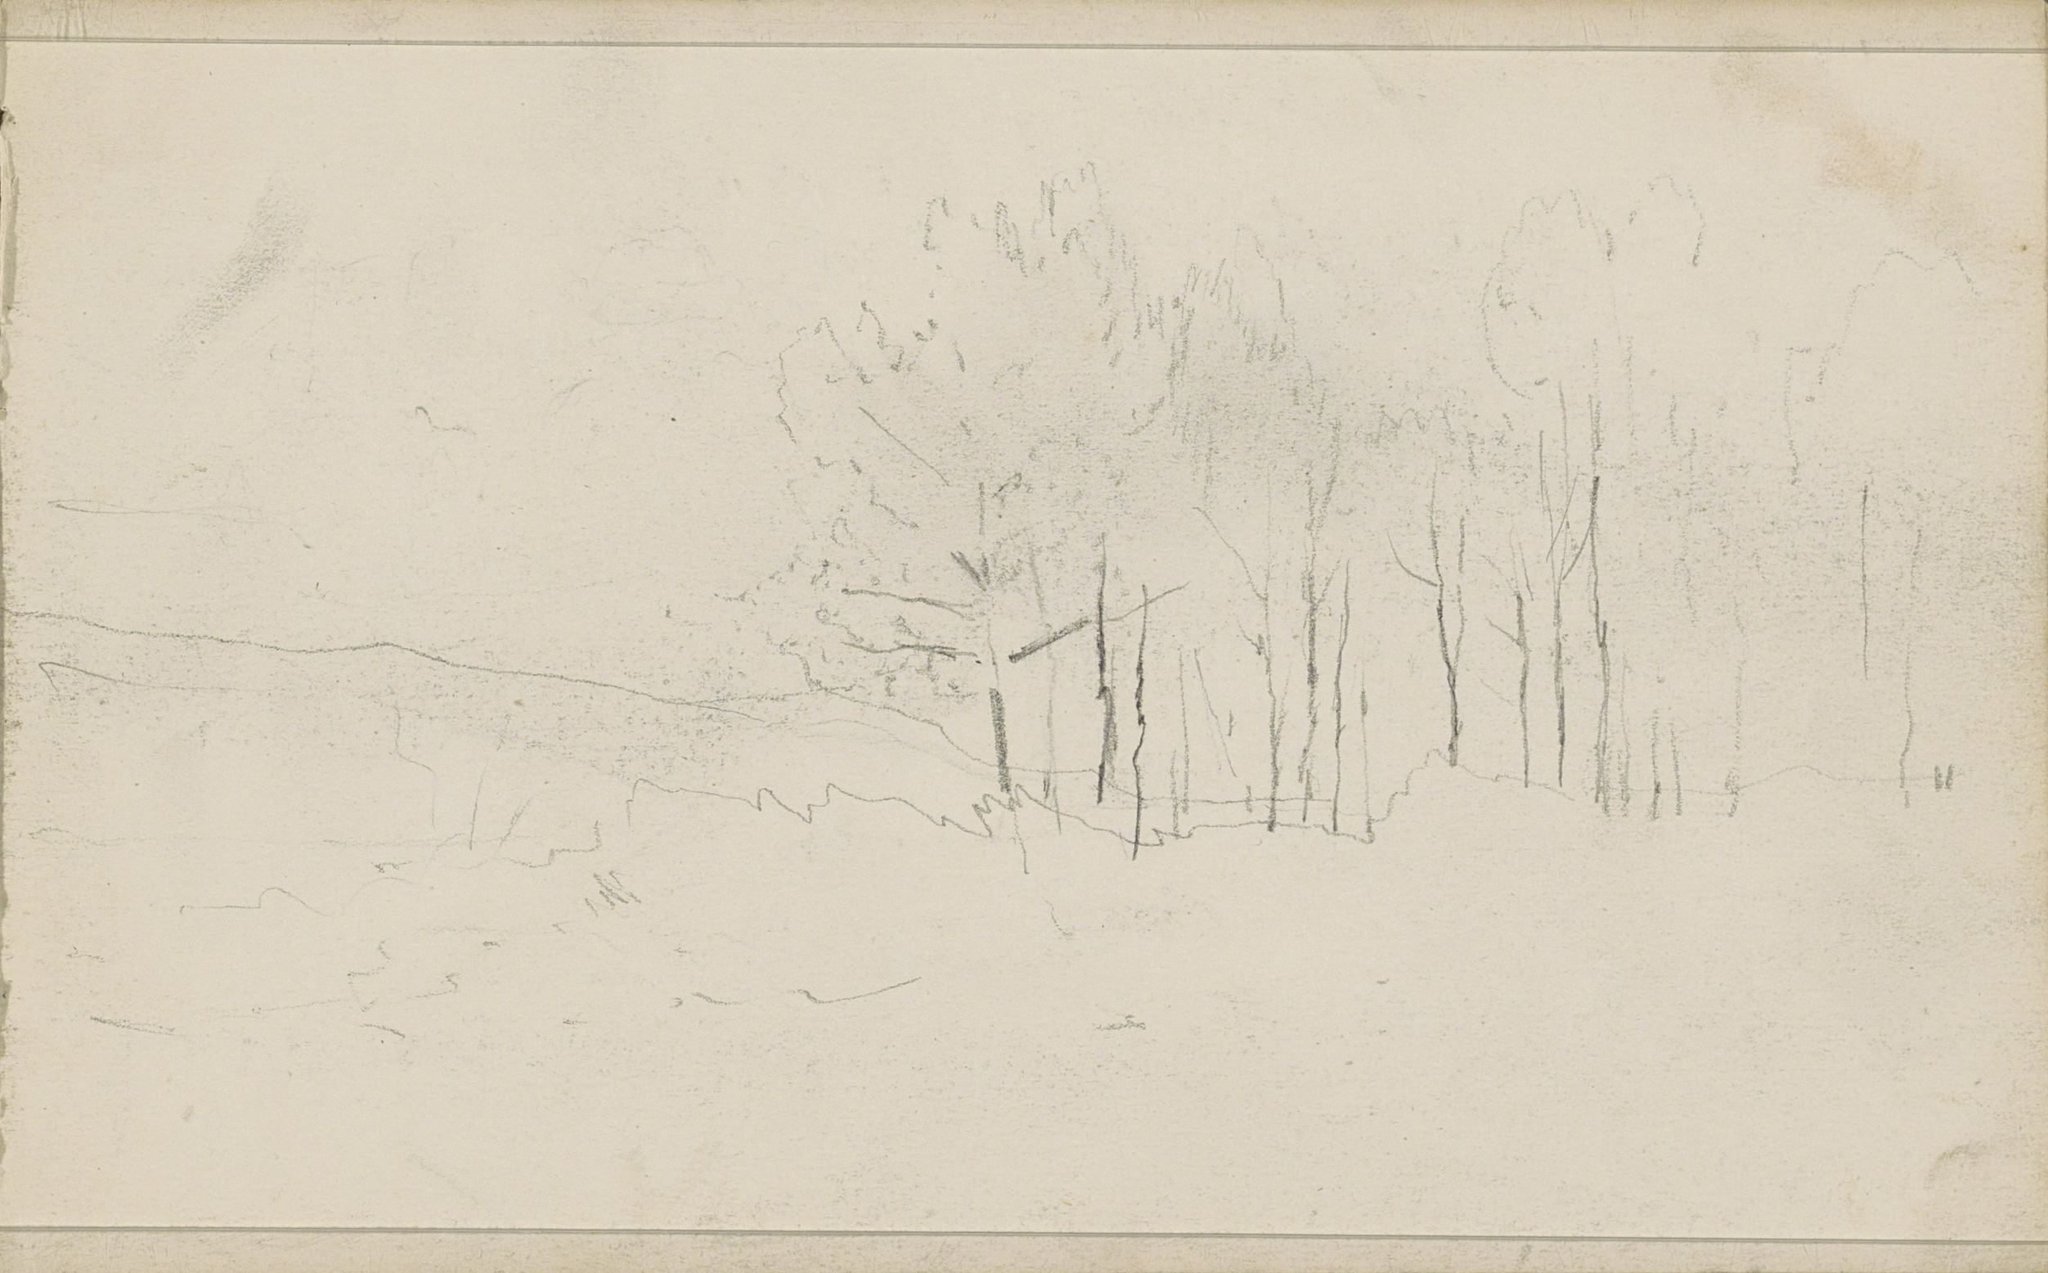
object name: sketchbook leaf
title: Landschap met bomen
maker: anton mauve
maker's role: draughtsman, painter, print maker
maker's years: 1838-1888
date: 1848-1888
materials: paper, pencil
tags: landscapes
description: Blad 5 recto uit een schetsboek met 42 bladen.